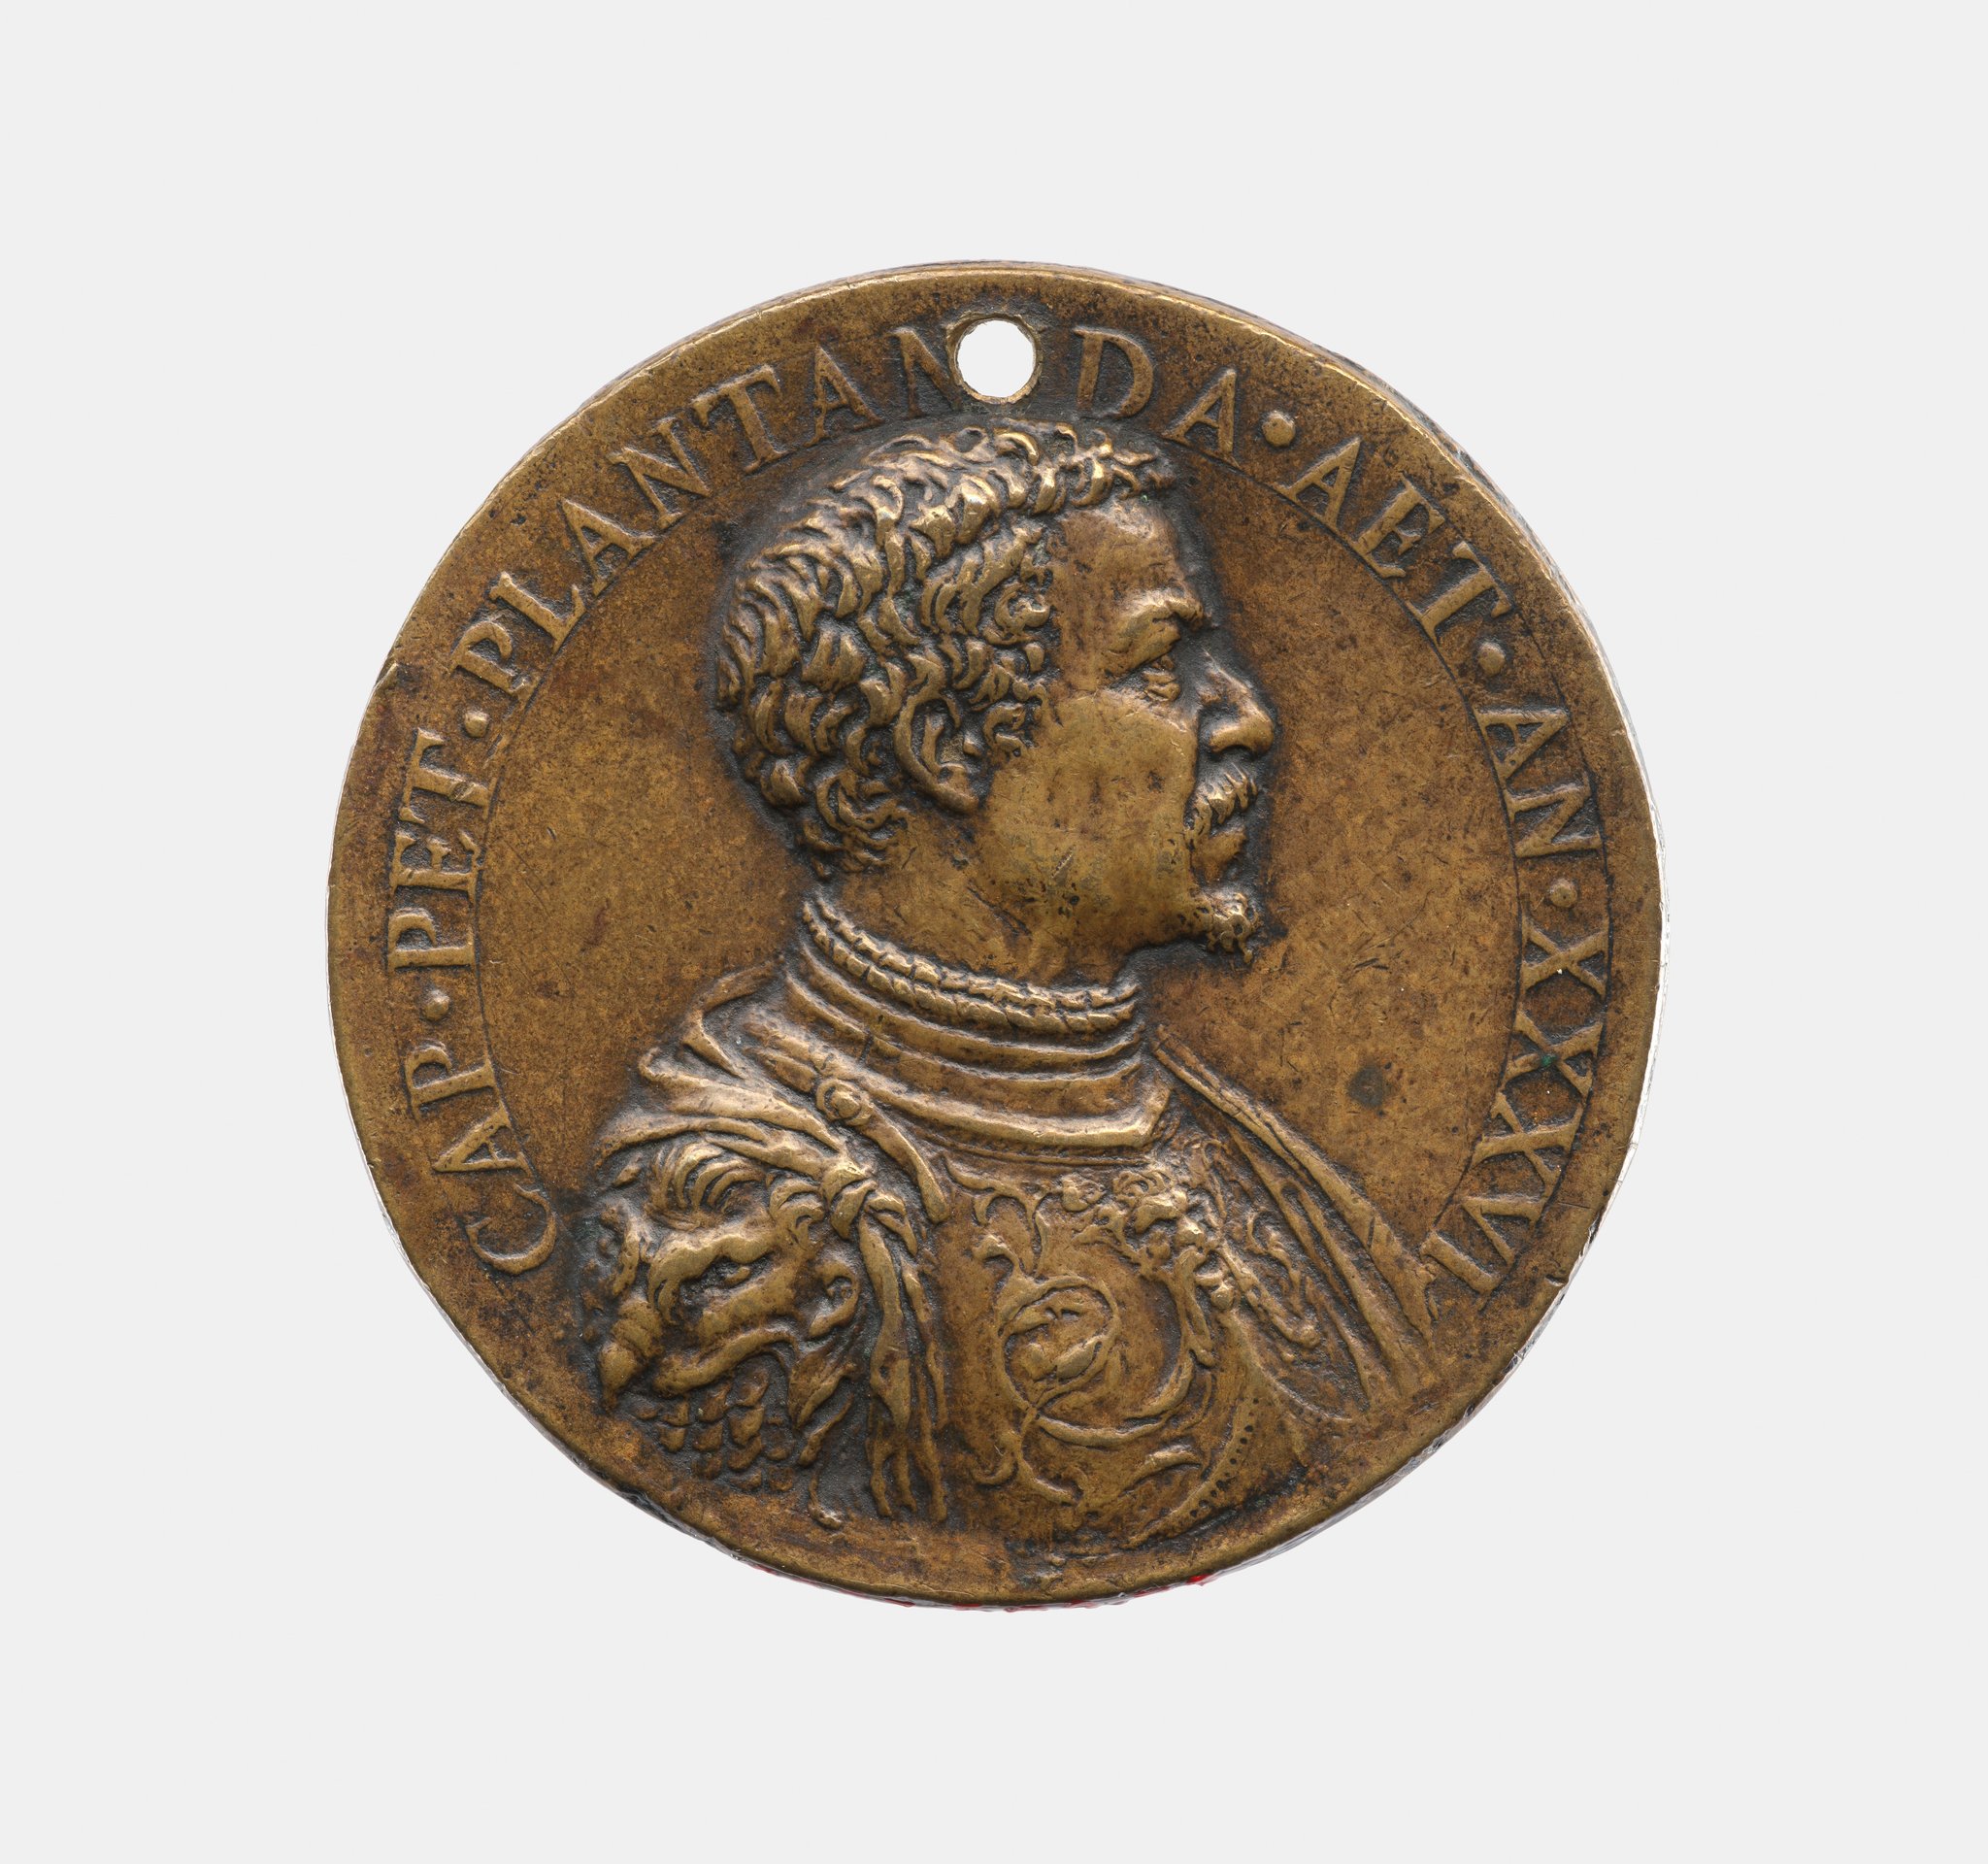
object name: medal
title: Pietro Piantanida, Milanese Captain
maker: Anonymous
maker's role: artist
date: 1500-1599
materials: bronze